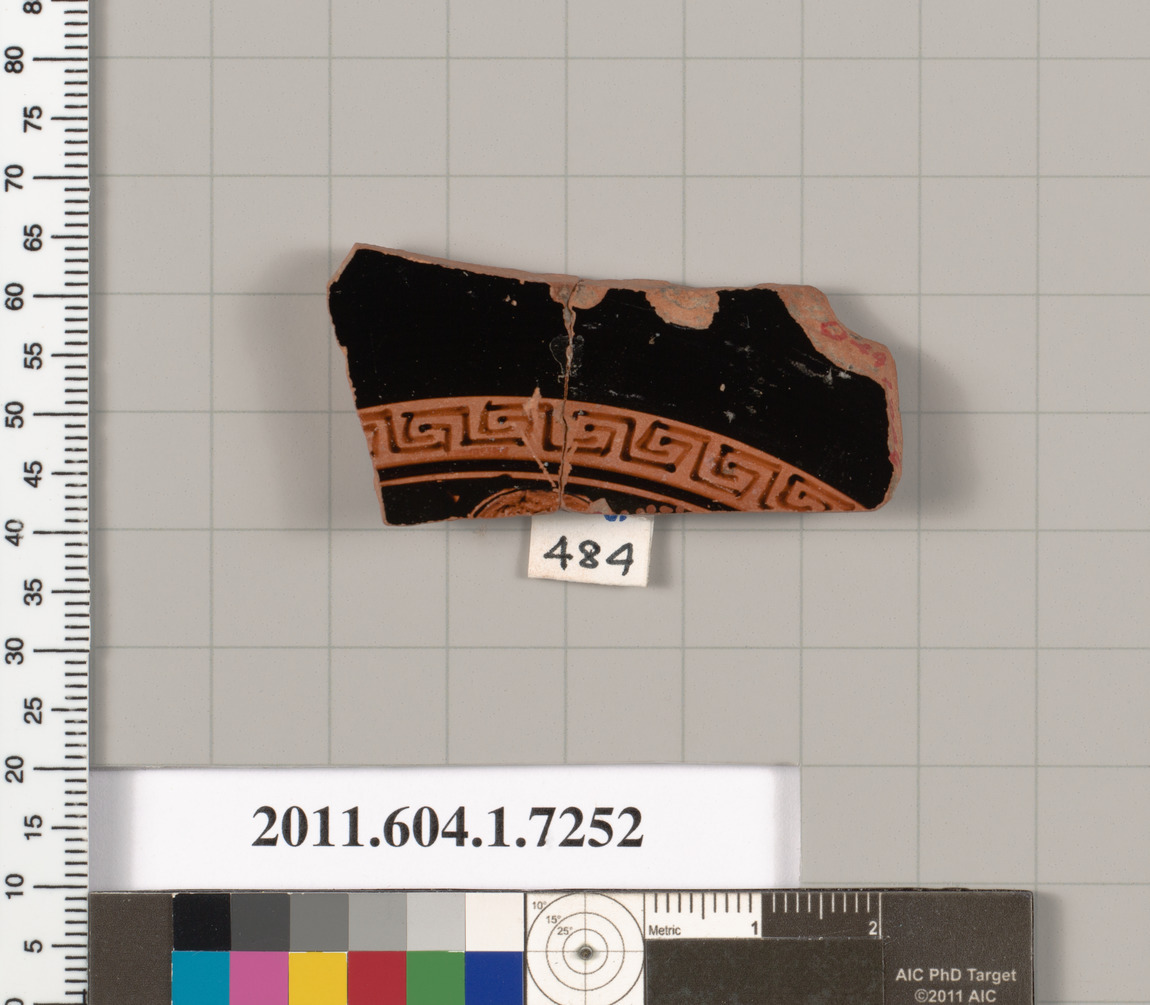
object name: kylix fragment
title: Terracotta fragment of a kylix (drinking cup)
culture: greek, attic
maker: makron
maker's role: artist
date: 500-480 BCE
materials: terracotta